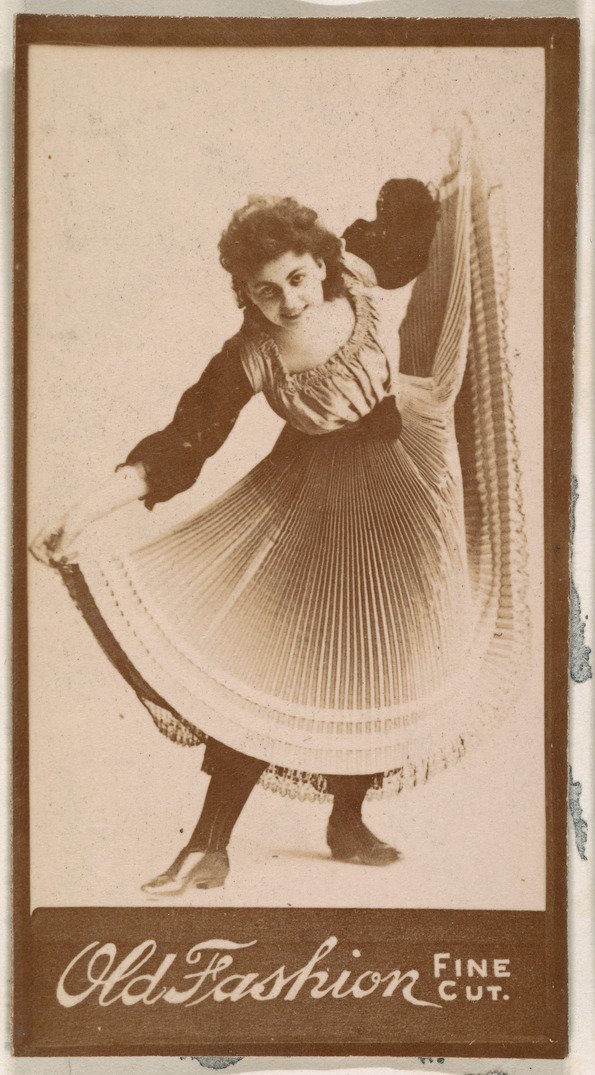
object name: photograph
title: Dancer, from the Actresses series (N664) promoting Old Fashion Fine Cut Tobacco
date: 1888-1890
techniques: albumen silver print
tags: portraits,women,dancers